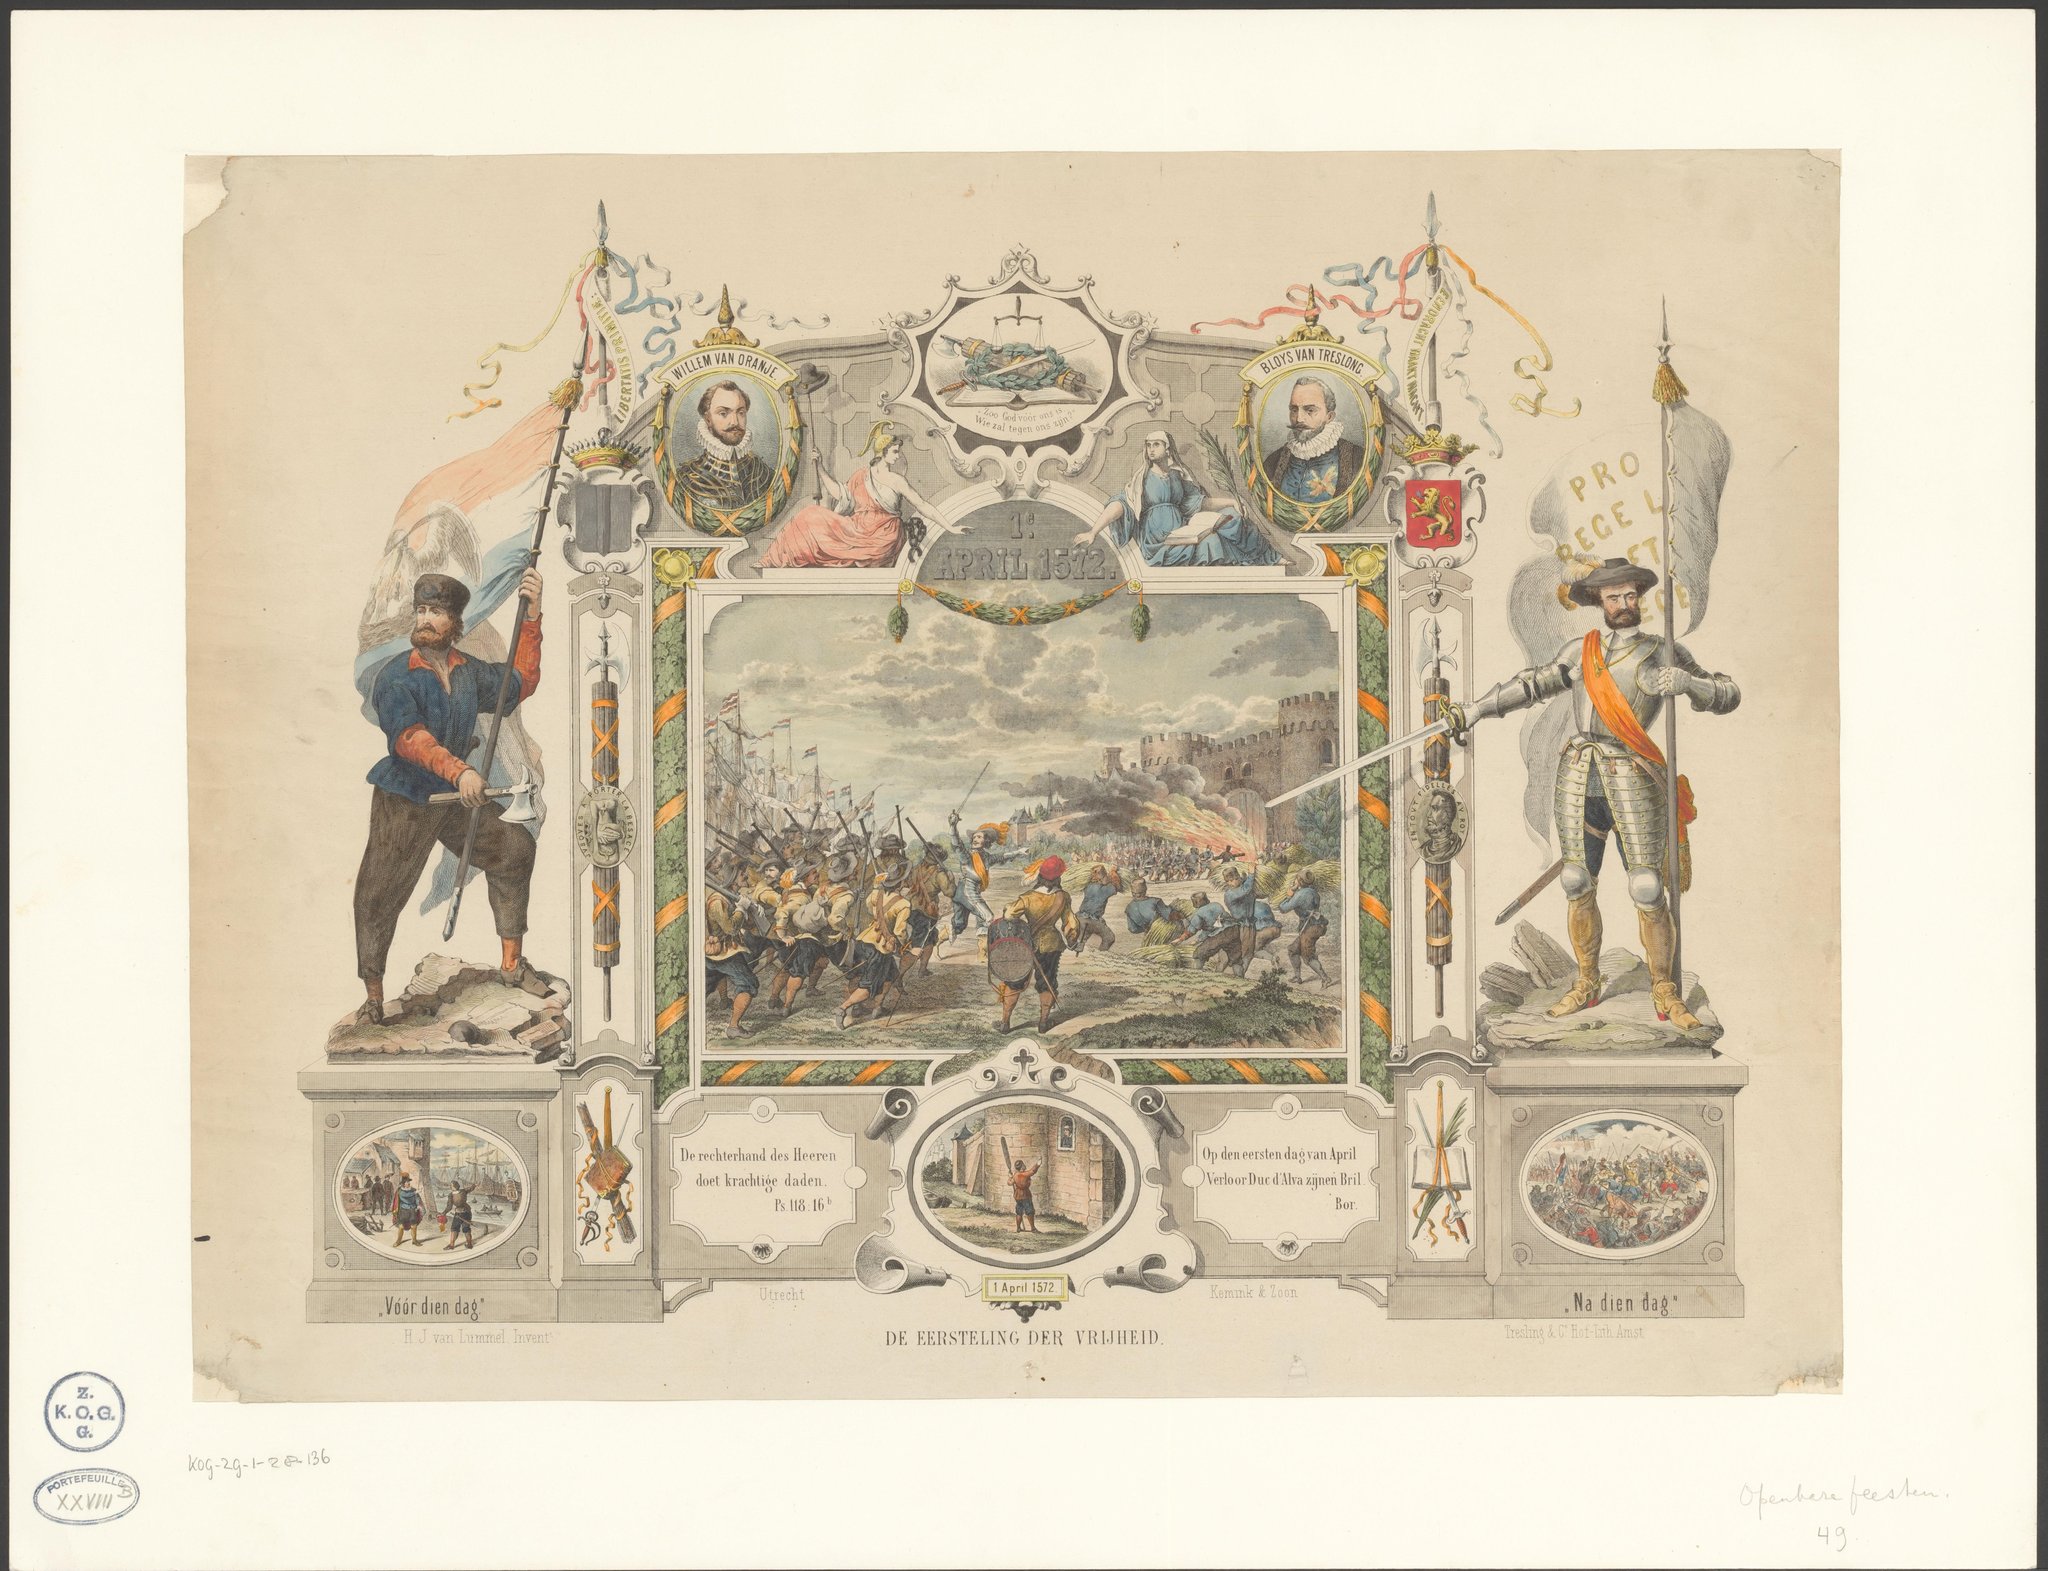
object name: print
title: Gedenkplaat bij de 300-jarige viering van de inneming van Den Briel, 1572-1872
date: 1872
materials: paper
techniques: hand coloring, lithograph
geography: amsterdam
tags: brielle, delft, william i (prince of orange), capture of city (after the siege)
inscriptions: stamp, collector's mark: Lugt 1641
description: Gedenkplaat van de inneming van Den Briel op 1 april 1572 bij de viering van 300 jaar Nederlandse vrijheid 1572-1872. Centraal het rammen van de poort door de watergeuzen onder Lumey. Links een watergeus, rechts een edelman. Bovenaan portretten van Willem van Oranje en Willem Bloys van Treslong. Onderaan drie kleine scènes met centraal Koppenstok die klopt op de poort van Den Briel. Bij de prent behoort een losse verklaring. Onderwerpsrubrieken binnen de Atlas Zeden en Gewoonten: Zeden en Gewoonten in Engeren Zin. Volksleven. Openbare feesten. Vorstelijke intochten, (Illuminaties, vuurwerken en dergelijke, openbare feesten).